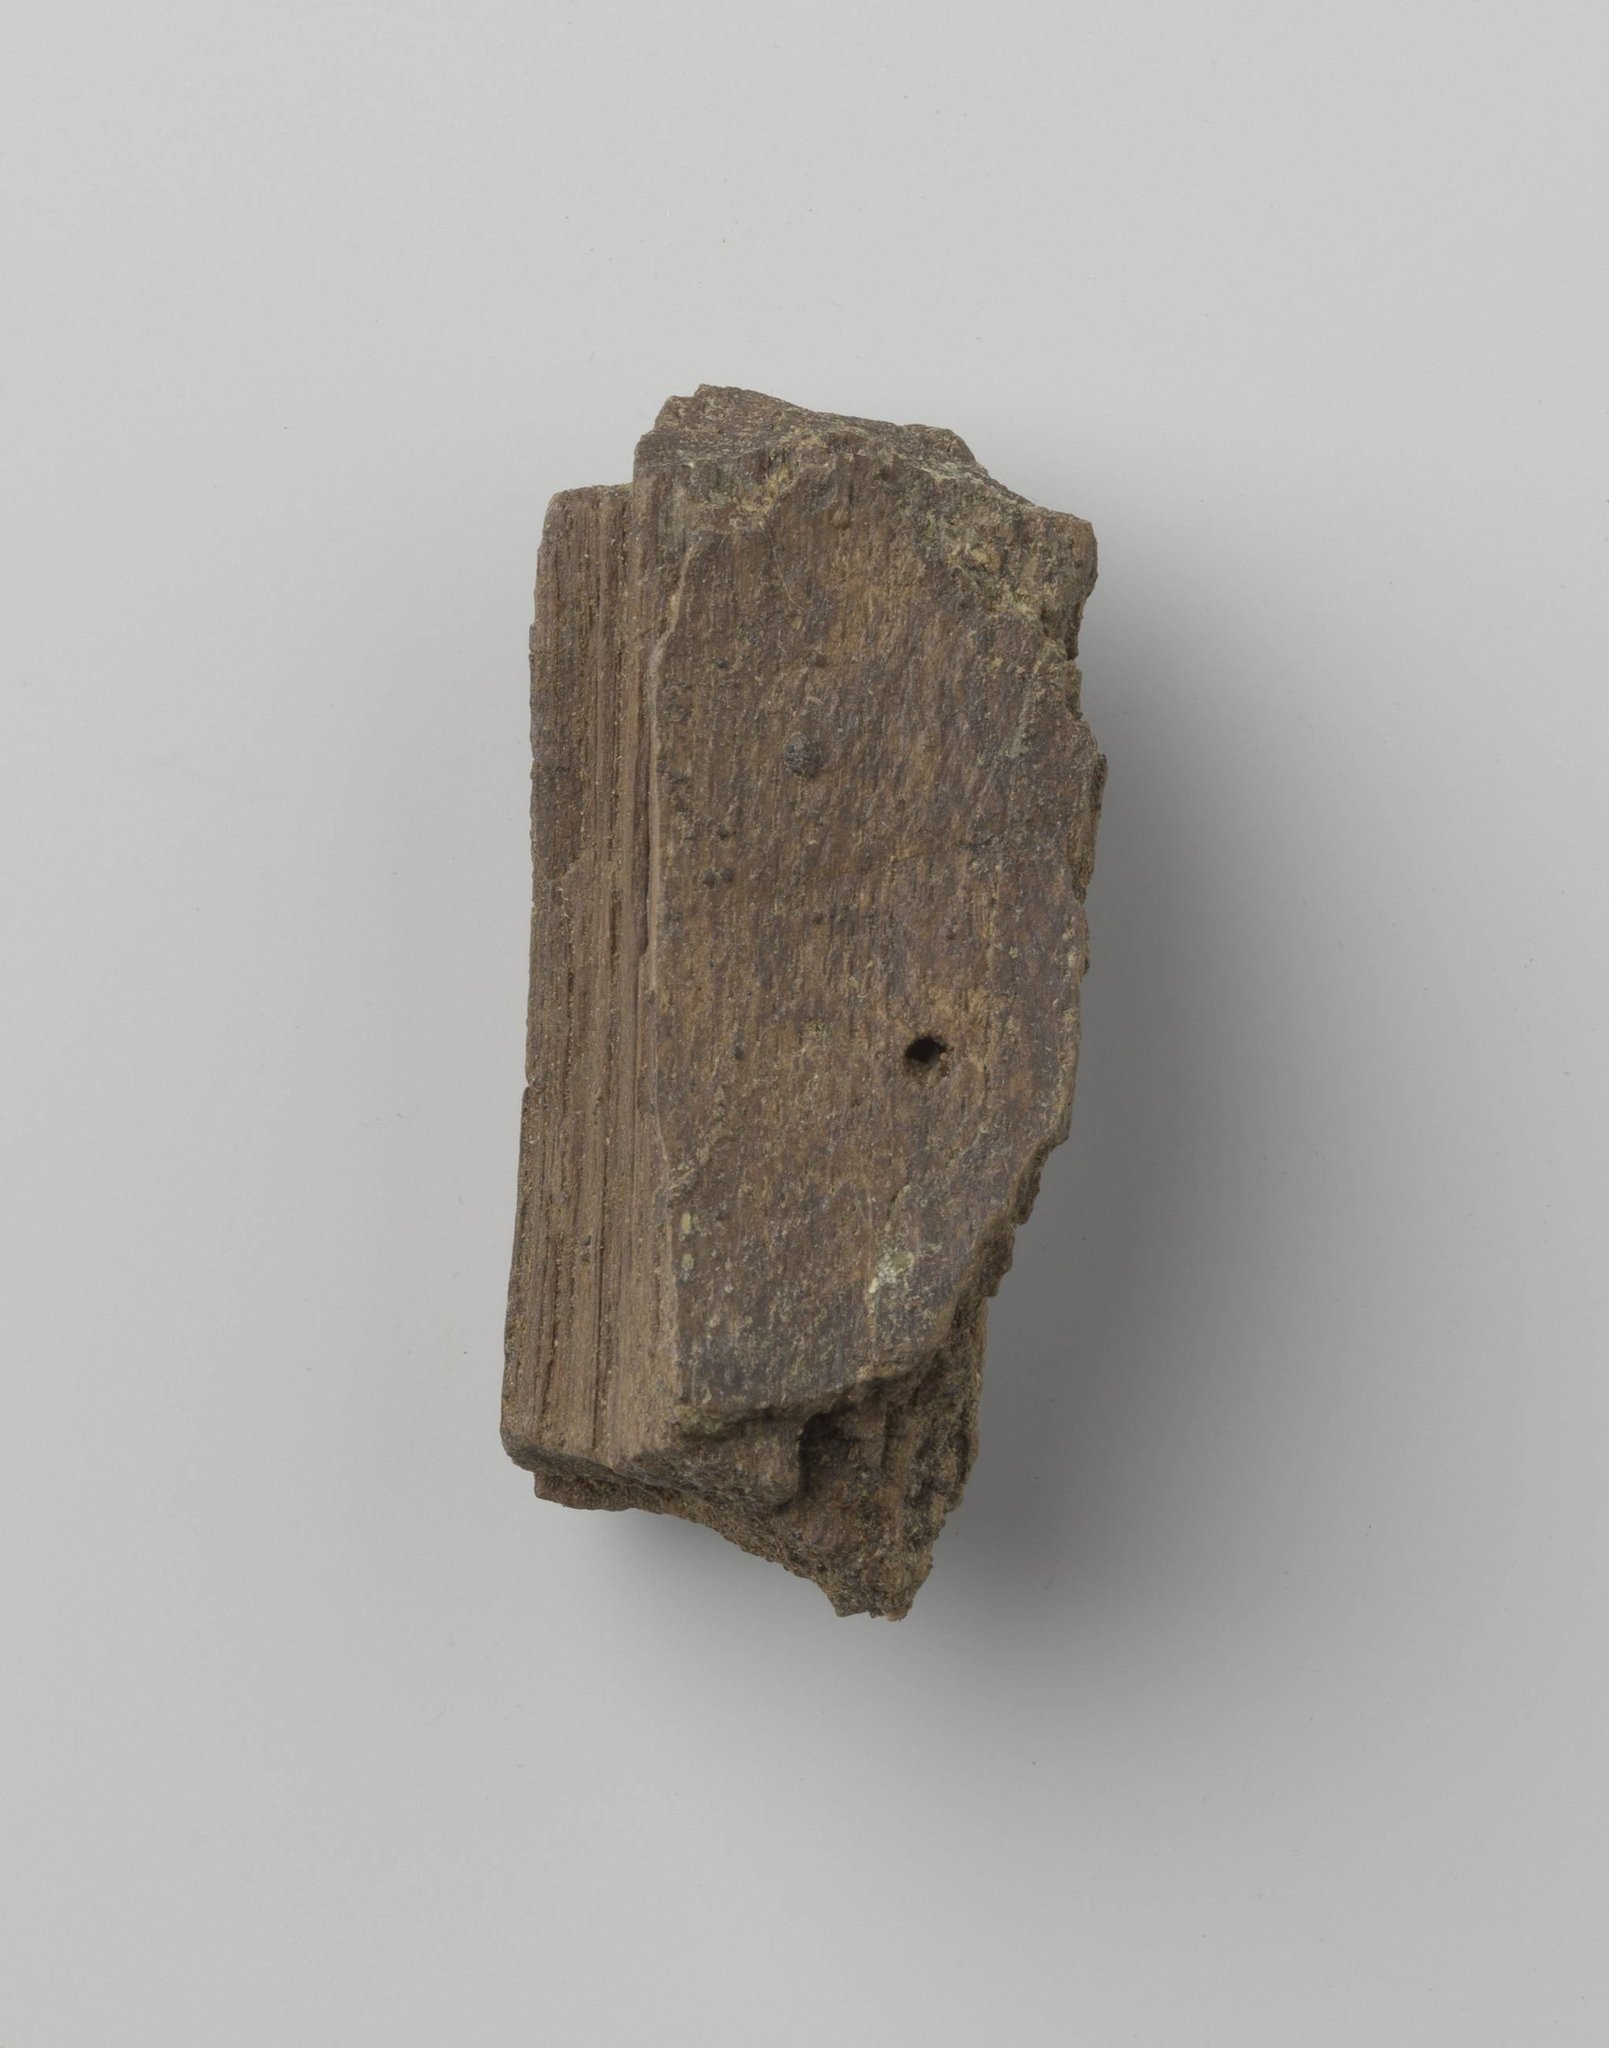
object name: sculpture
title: Fragment; (mogelijk) behorend tot het retabel van Soest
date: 1475-1499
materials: wood